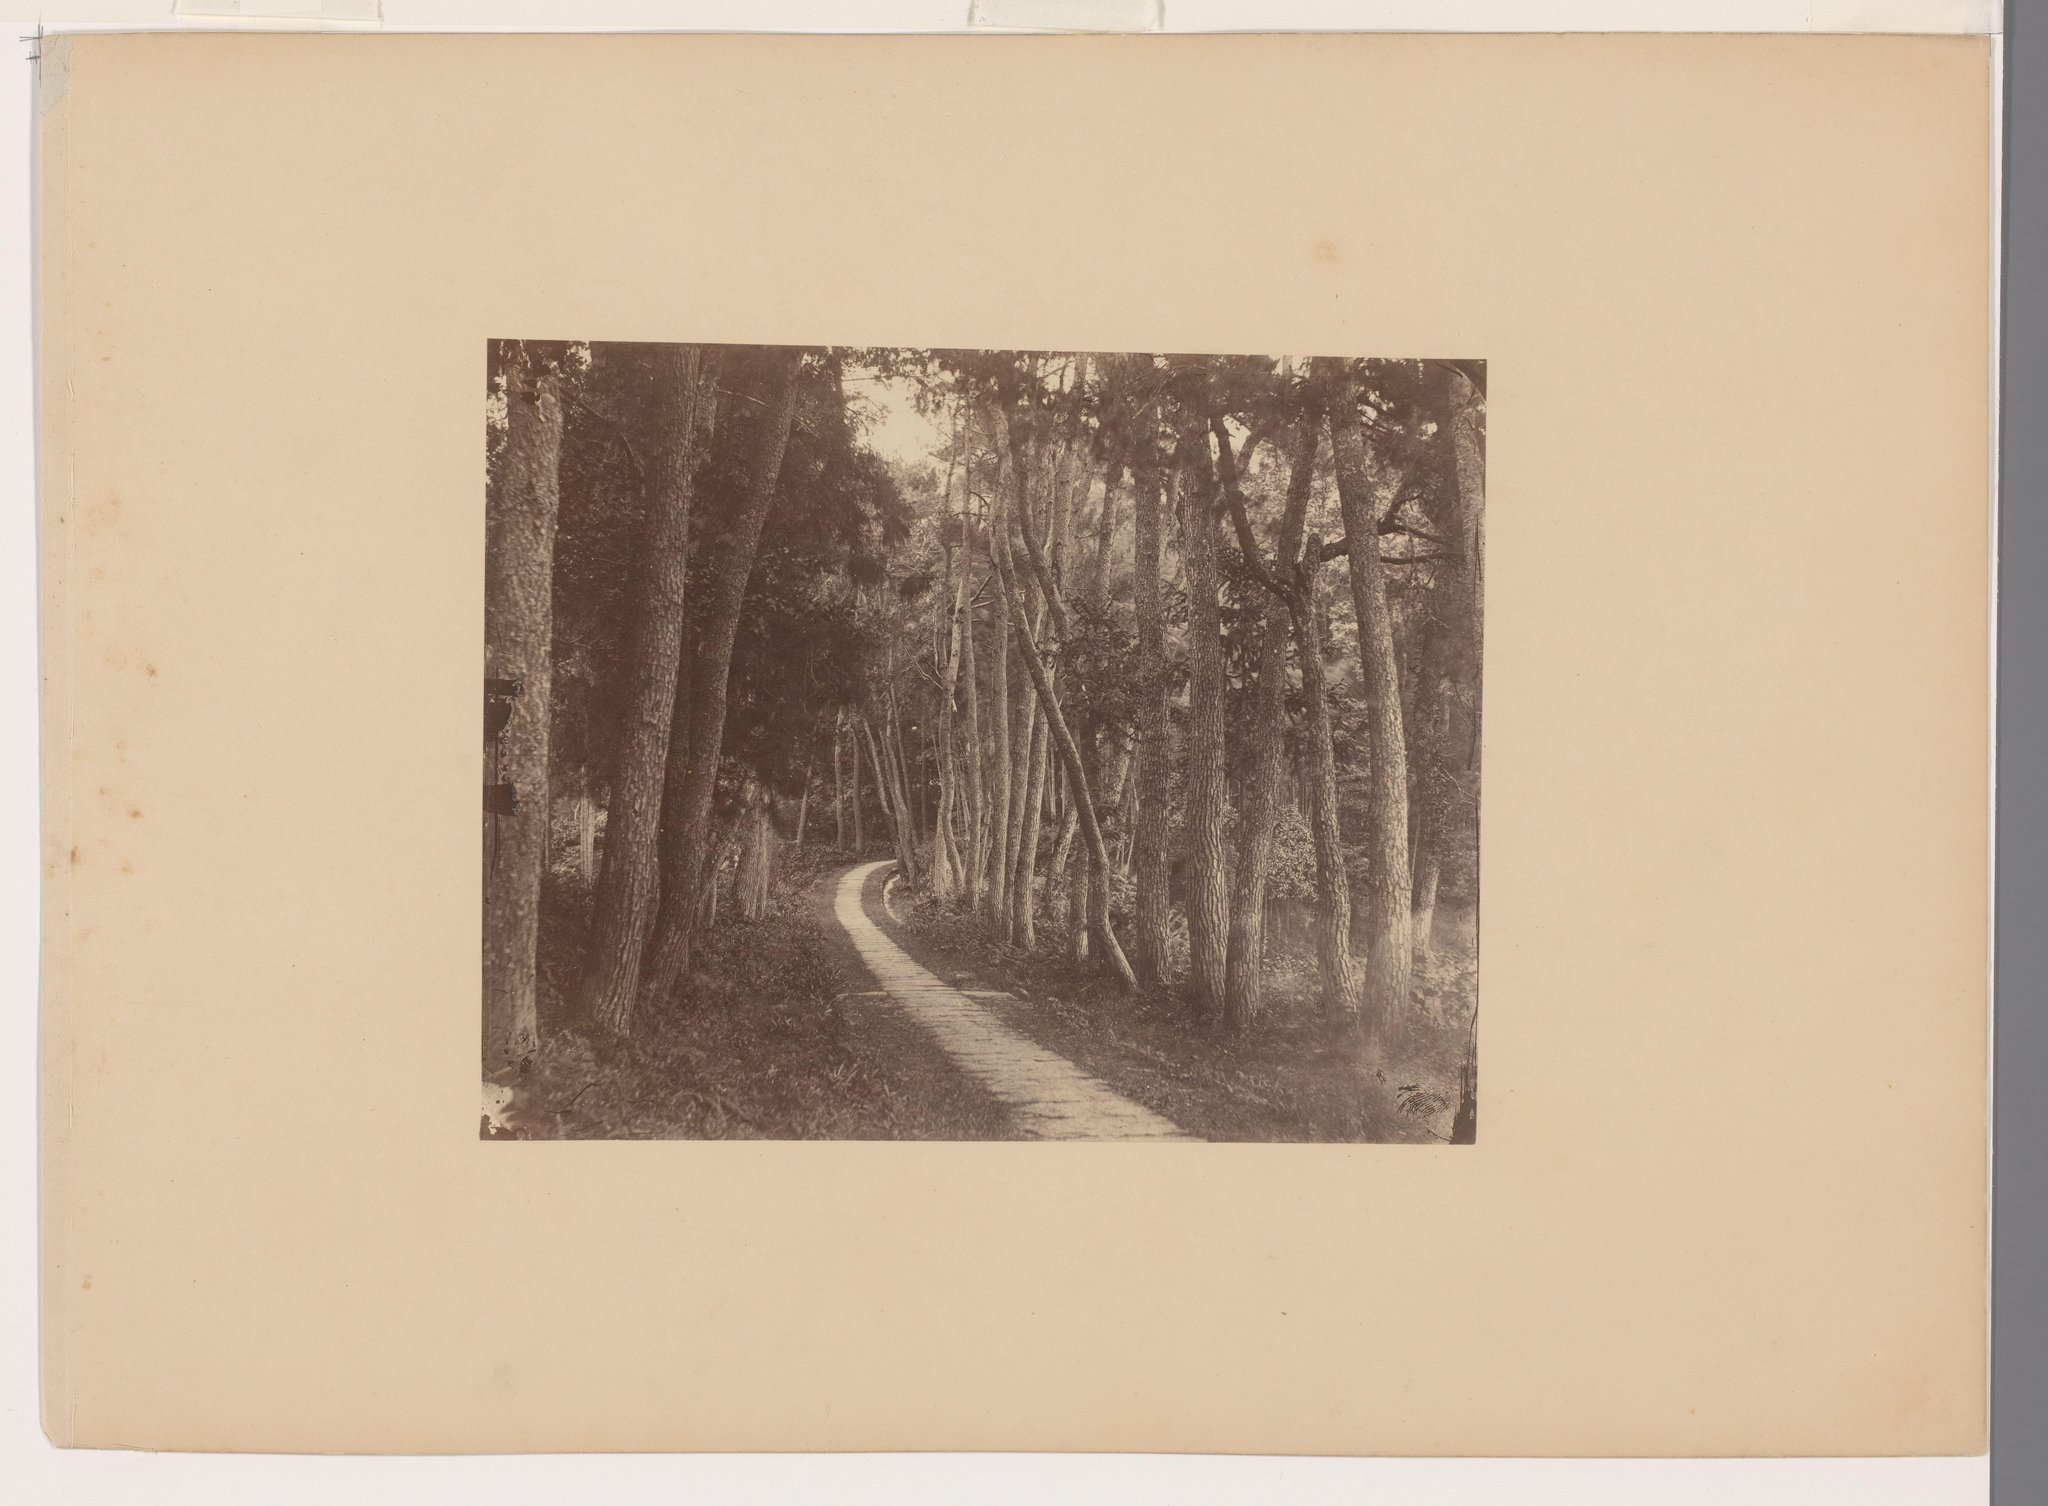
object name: photograph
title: Gezicht op een bospad te China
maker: Anonymous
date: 1860-1870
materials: cardboard, photographic support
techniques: albumen print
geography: china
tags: forest path or lane, china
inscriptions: annotation: ‘China 1860s/ A22’